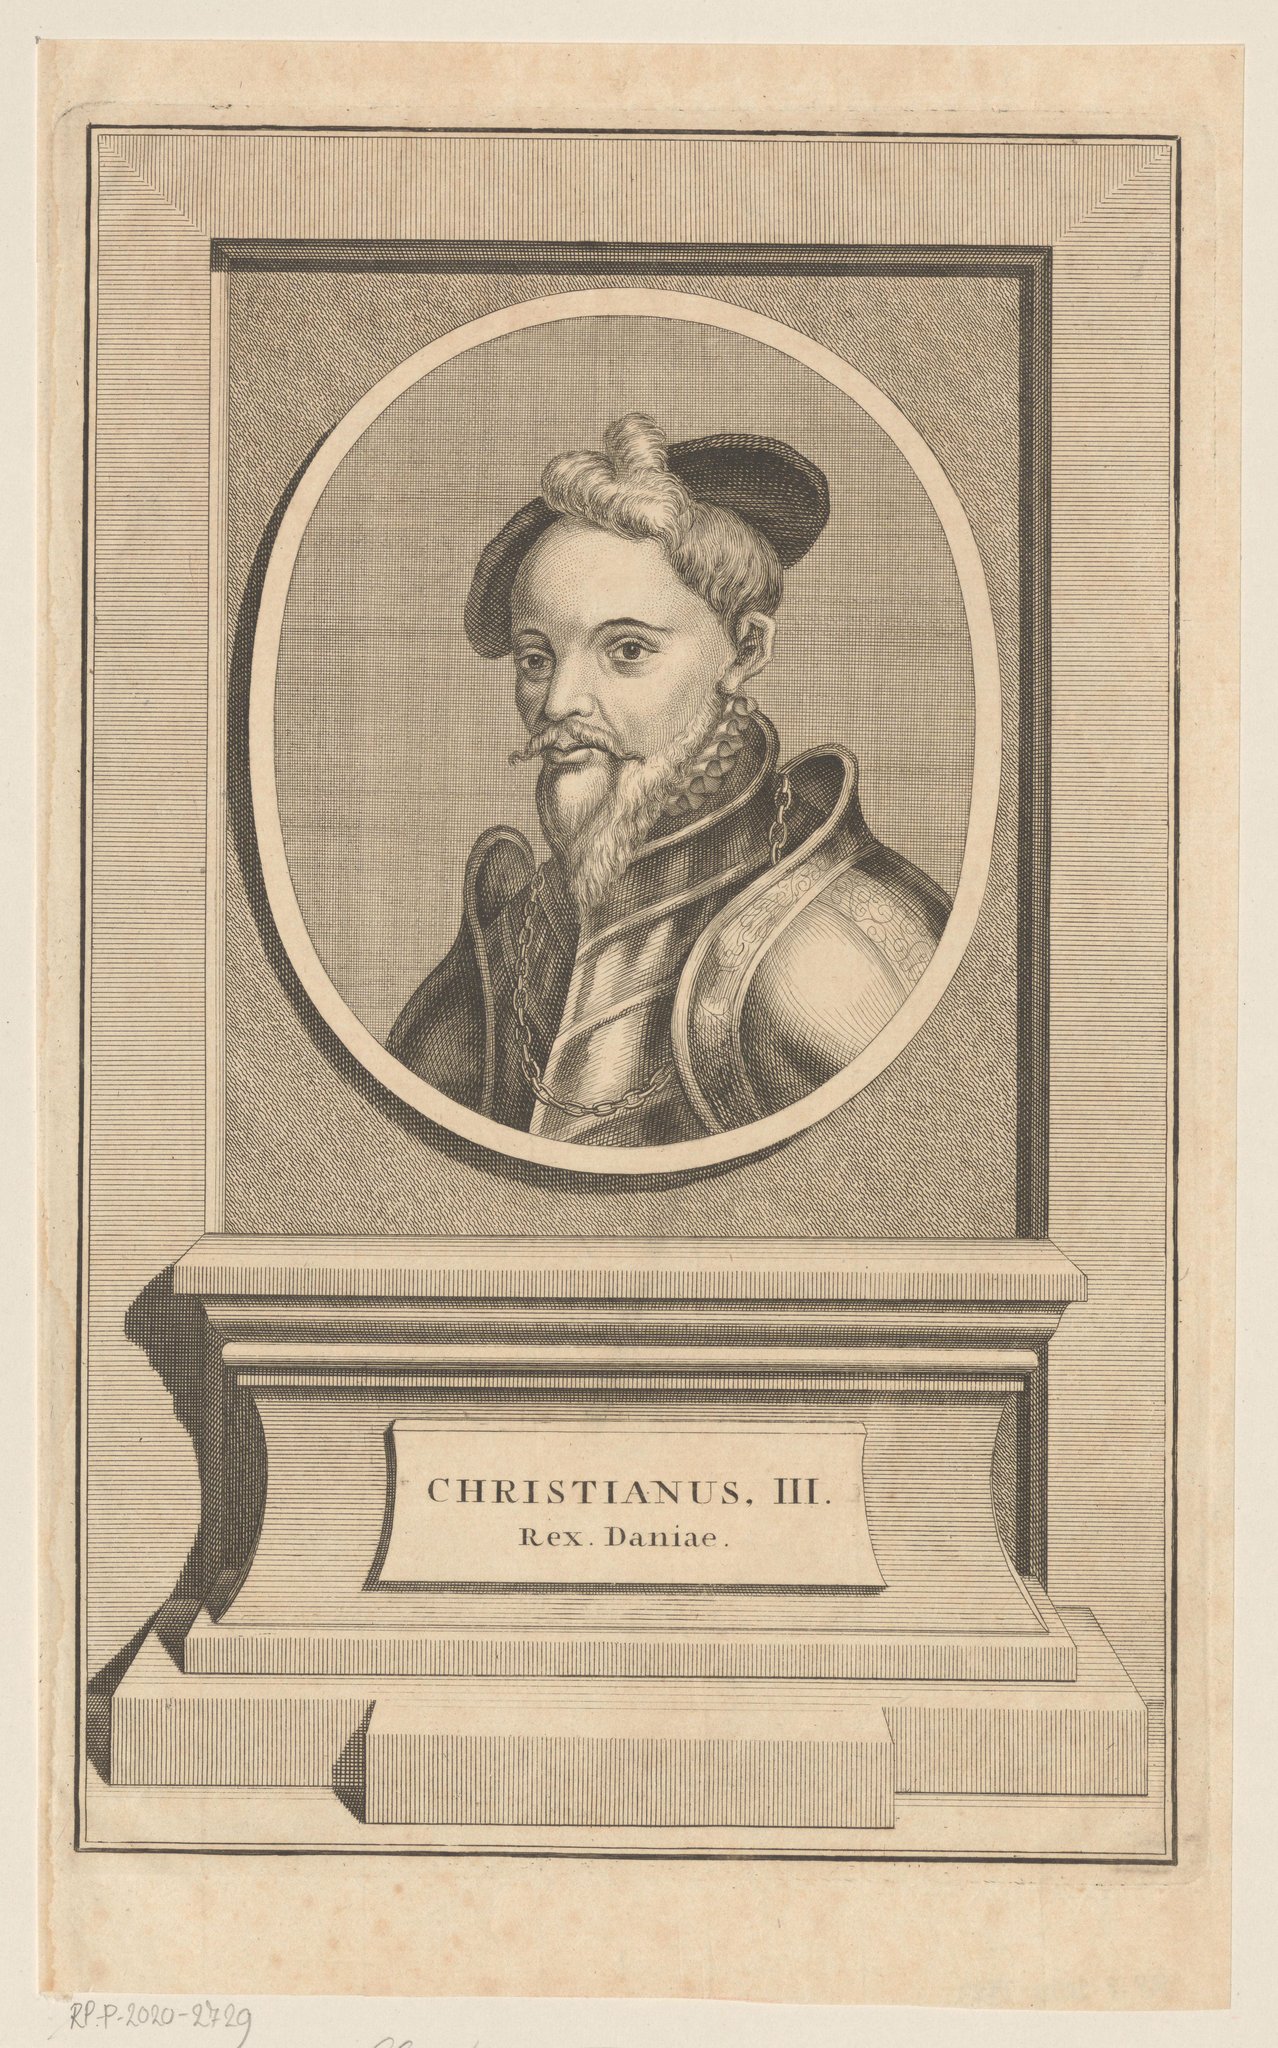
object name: print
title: Portret van Christiaan III, koning van Denemarken en Noorwegen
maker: Anonymous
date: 1718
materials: paper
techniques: etching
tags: historical persons, king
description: Prent waarschijnlijk uit: Seckendorf, Veit Ludwig. Uitvoerige en onpartydige historie der Reformatie door dr. Martin Luther. Delft: Reinier Boitet, 1718, dl. 2.